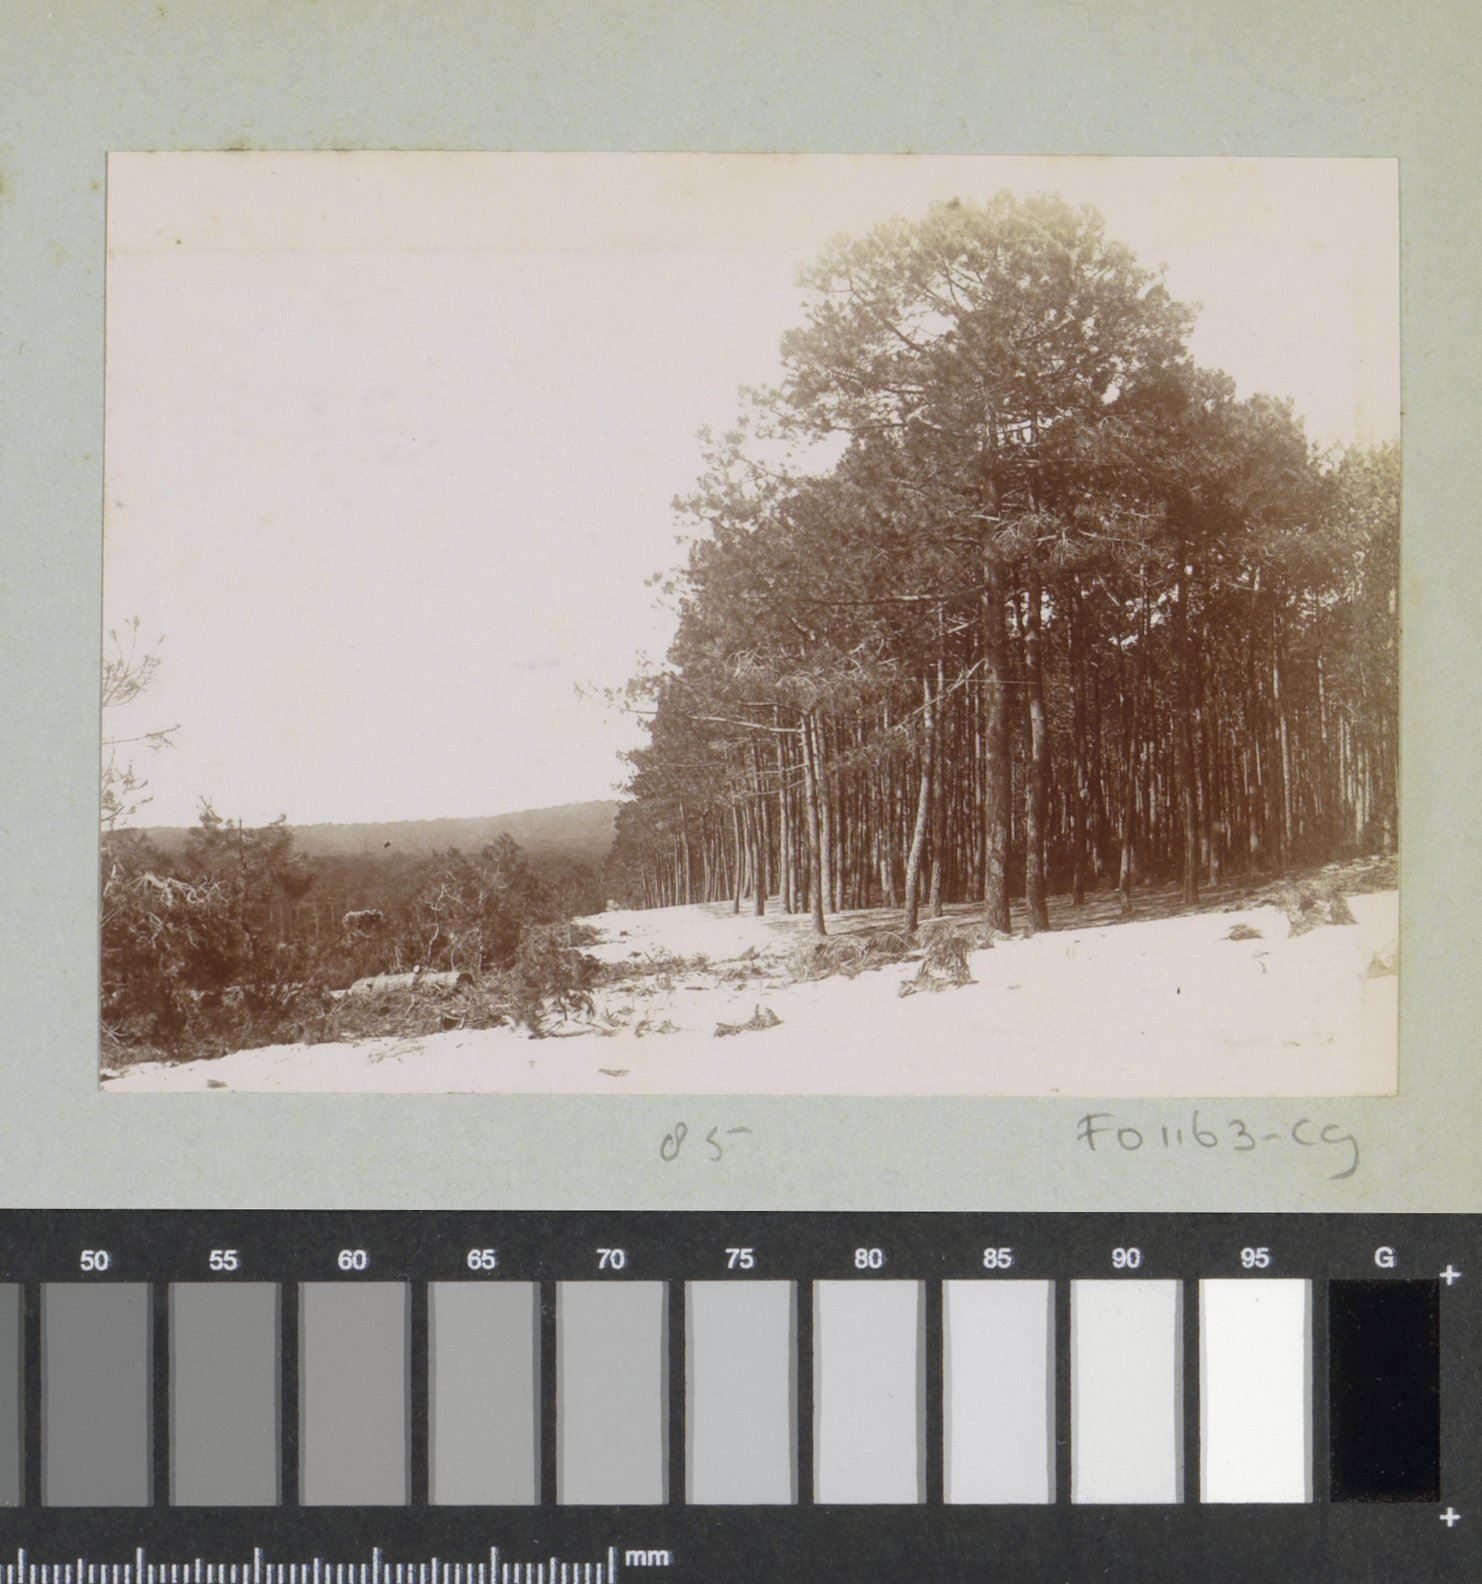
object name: photograph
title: Bosrand met pad bij Arachon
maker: delizy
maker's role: manufacturer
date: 1803-1897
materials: paper, photographic support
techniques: gelatin silver print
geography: arcachon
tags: road, path, forest, wood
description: Onderdeel van Fotoalbum van een Franse amateurfotograaf met opnames van uitstapjes in Frankrijk, Spanje, België, Luxemburg en Nederland, de eerste automobielen en autoraces.